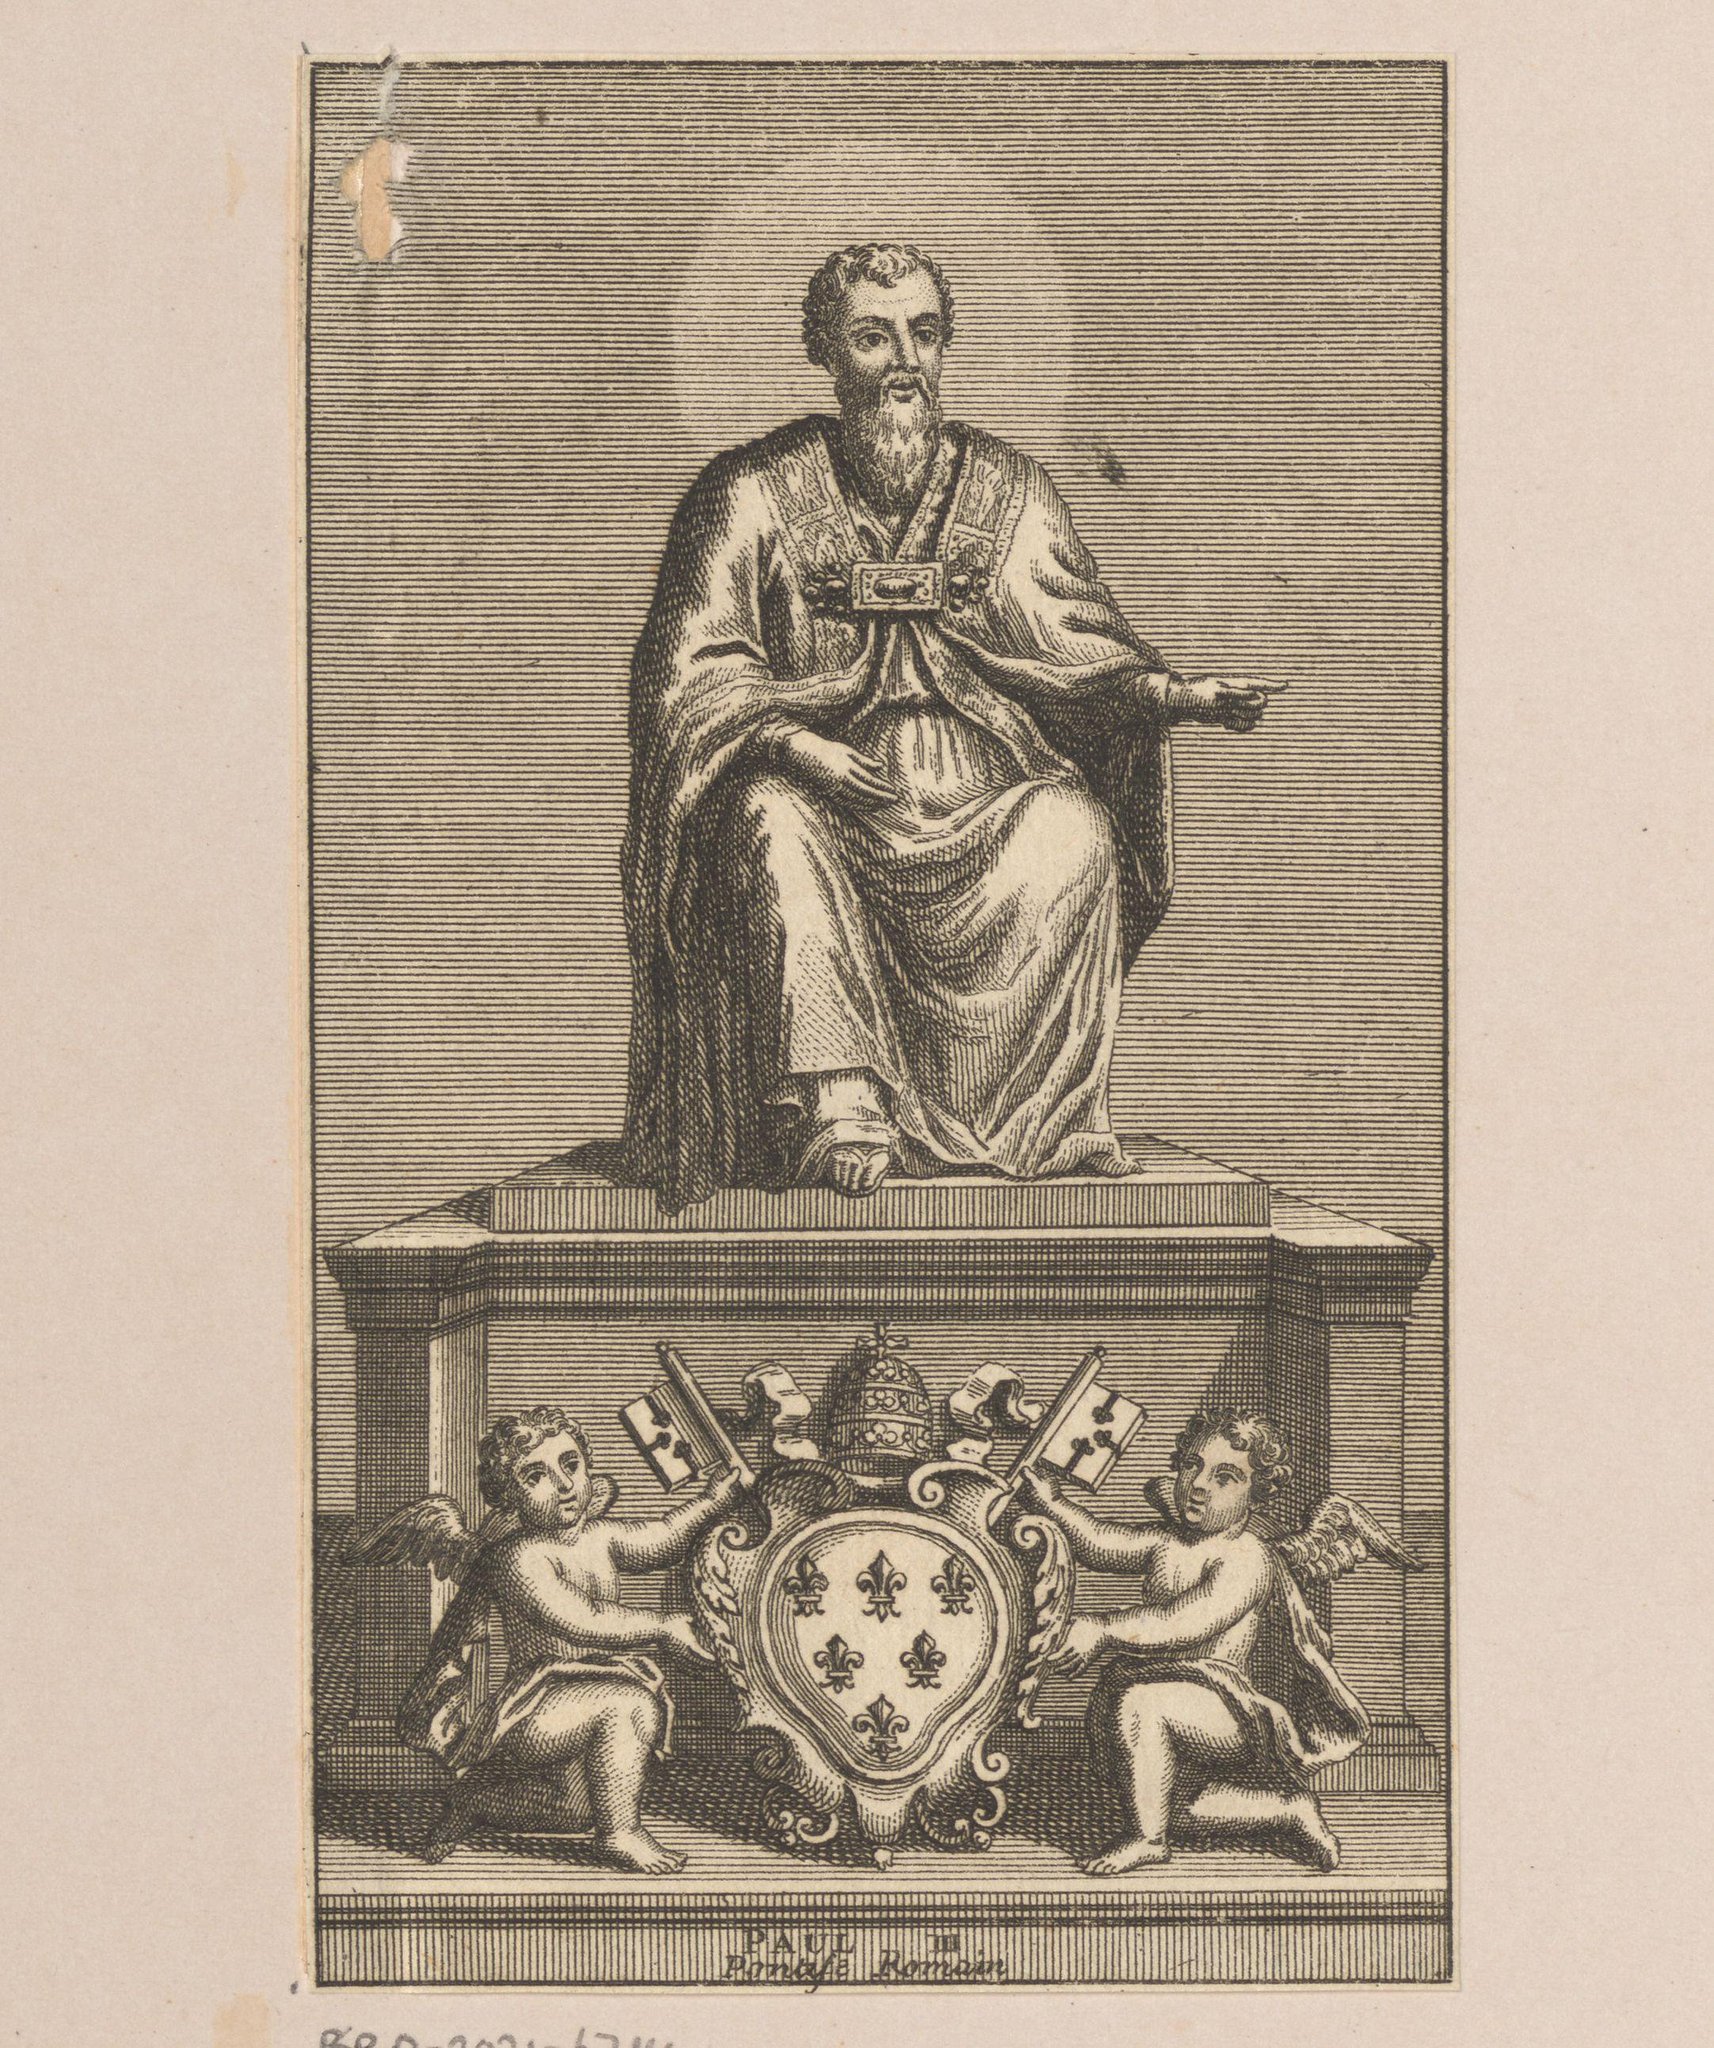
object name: print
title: Portret van paus Paulus III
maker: Anonymous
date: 1650-1749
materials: paper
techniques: etching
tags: priest, paulus iii, adult man, historical persons, pope, armorial bearing, heraldry